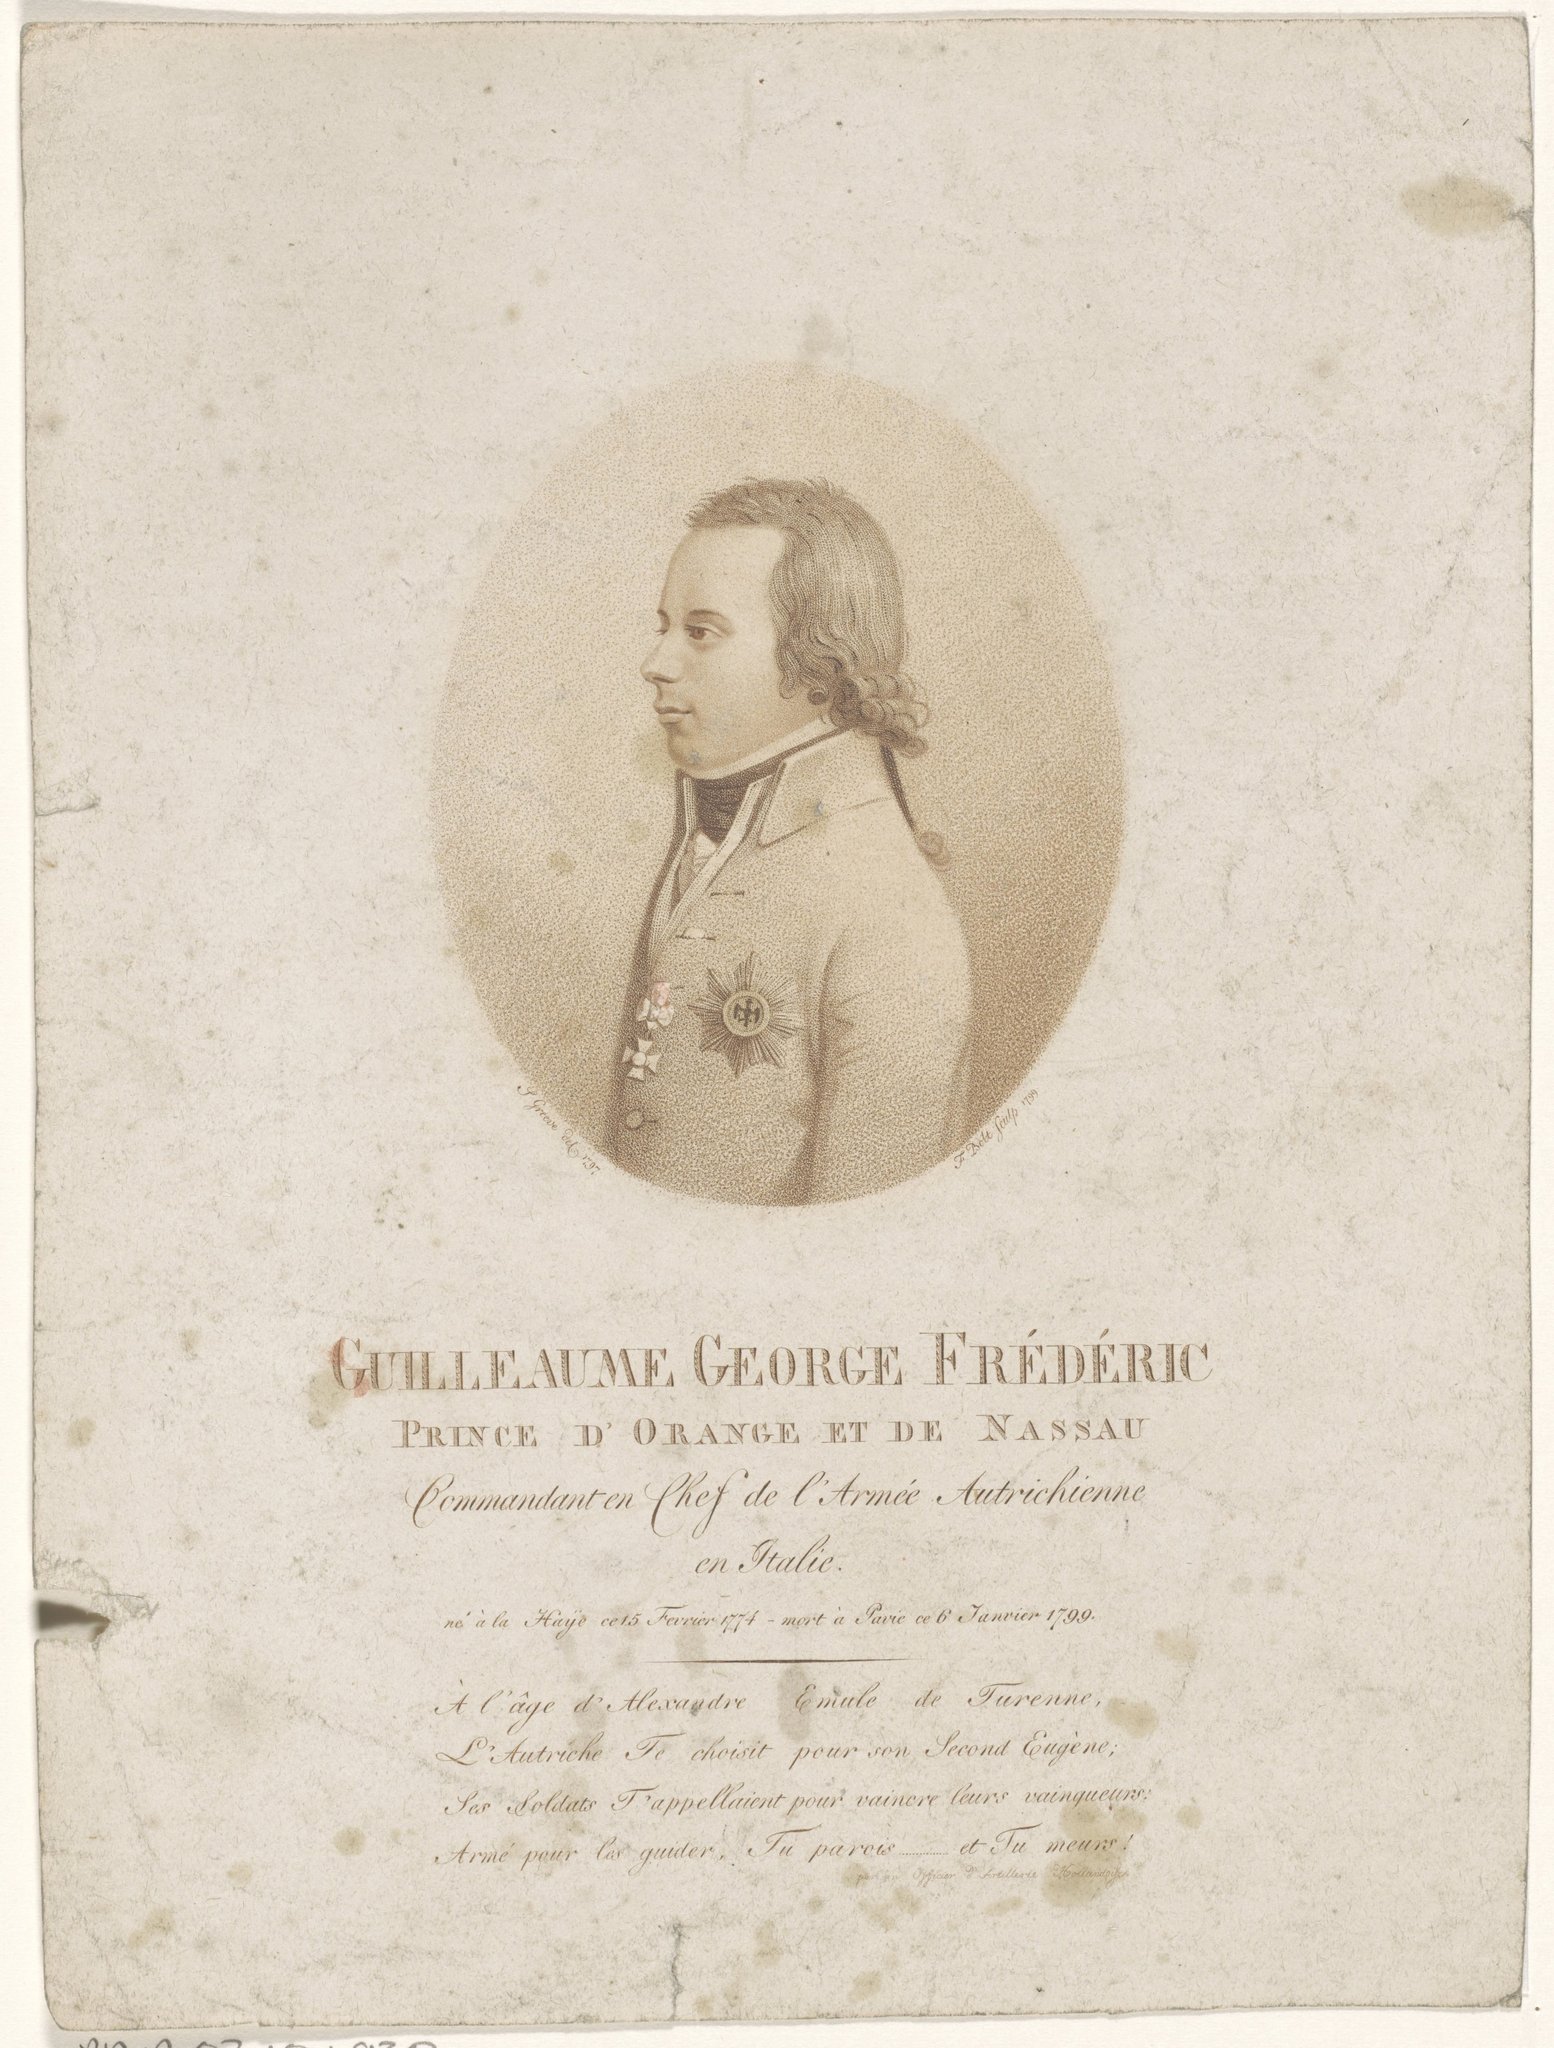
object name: print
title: Portret van prins Willem George Frederik van Oranje-Nassau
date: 1799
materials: paper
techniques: aquatint, engraving, etching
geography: berlin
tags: willem george frederik (prins van oranje-nassau)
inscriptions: date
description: Portret van prins Willem George Frederik van Oranje-Nassau in een ovaal. In de ondermarge negen regels Franse tekst.